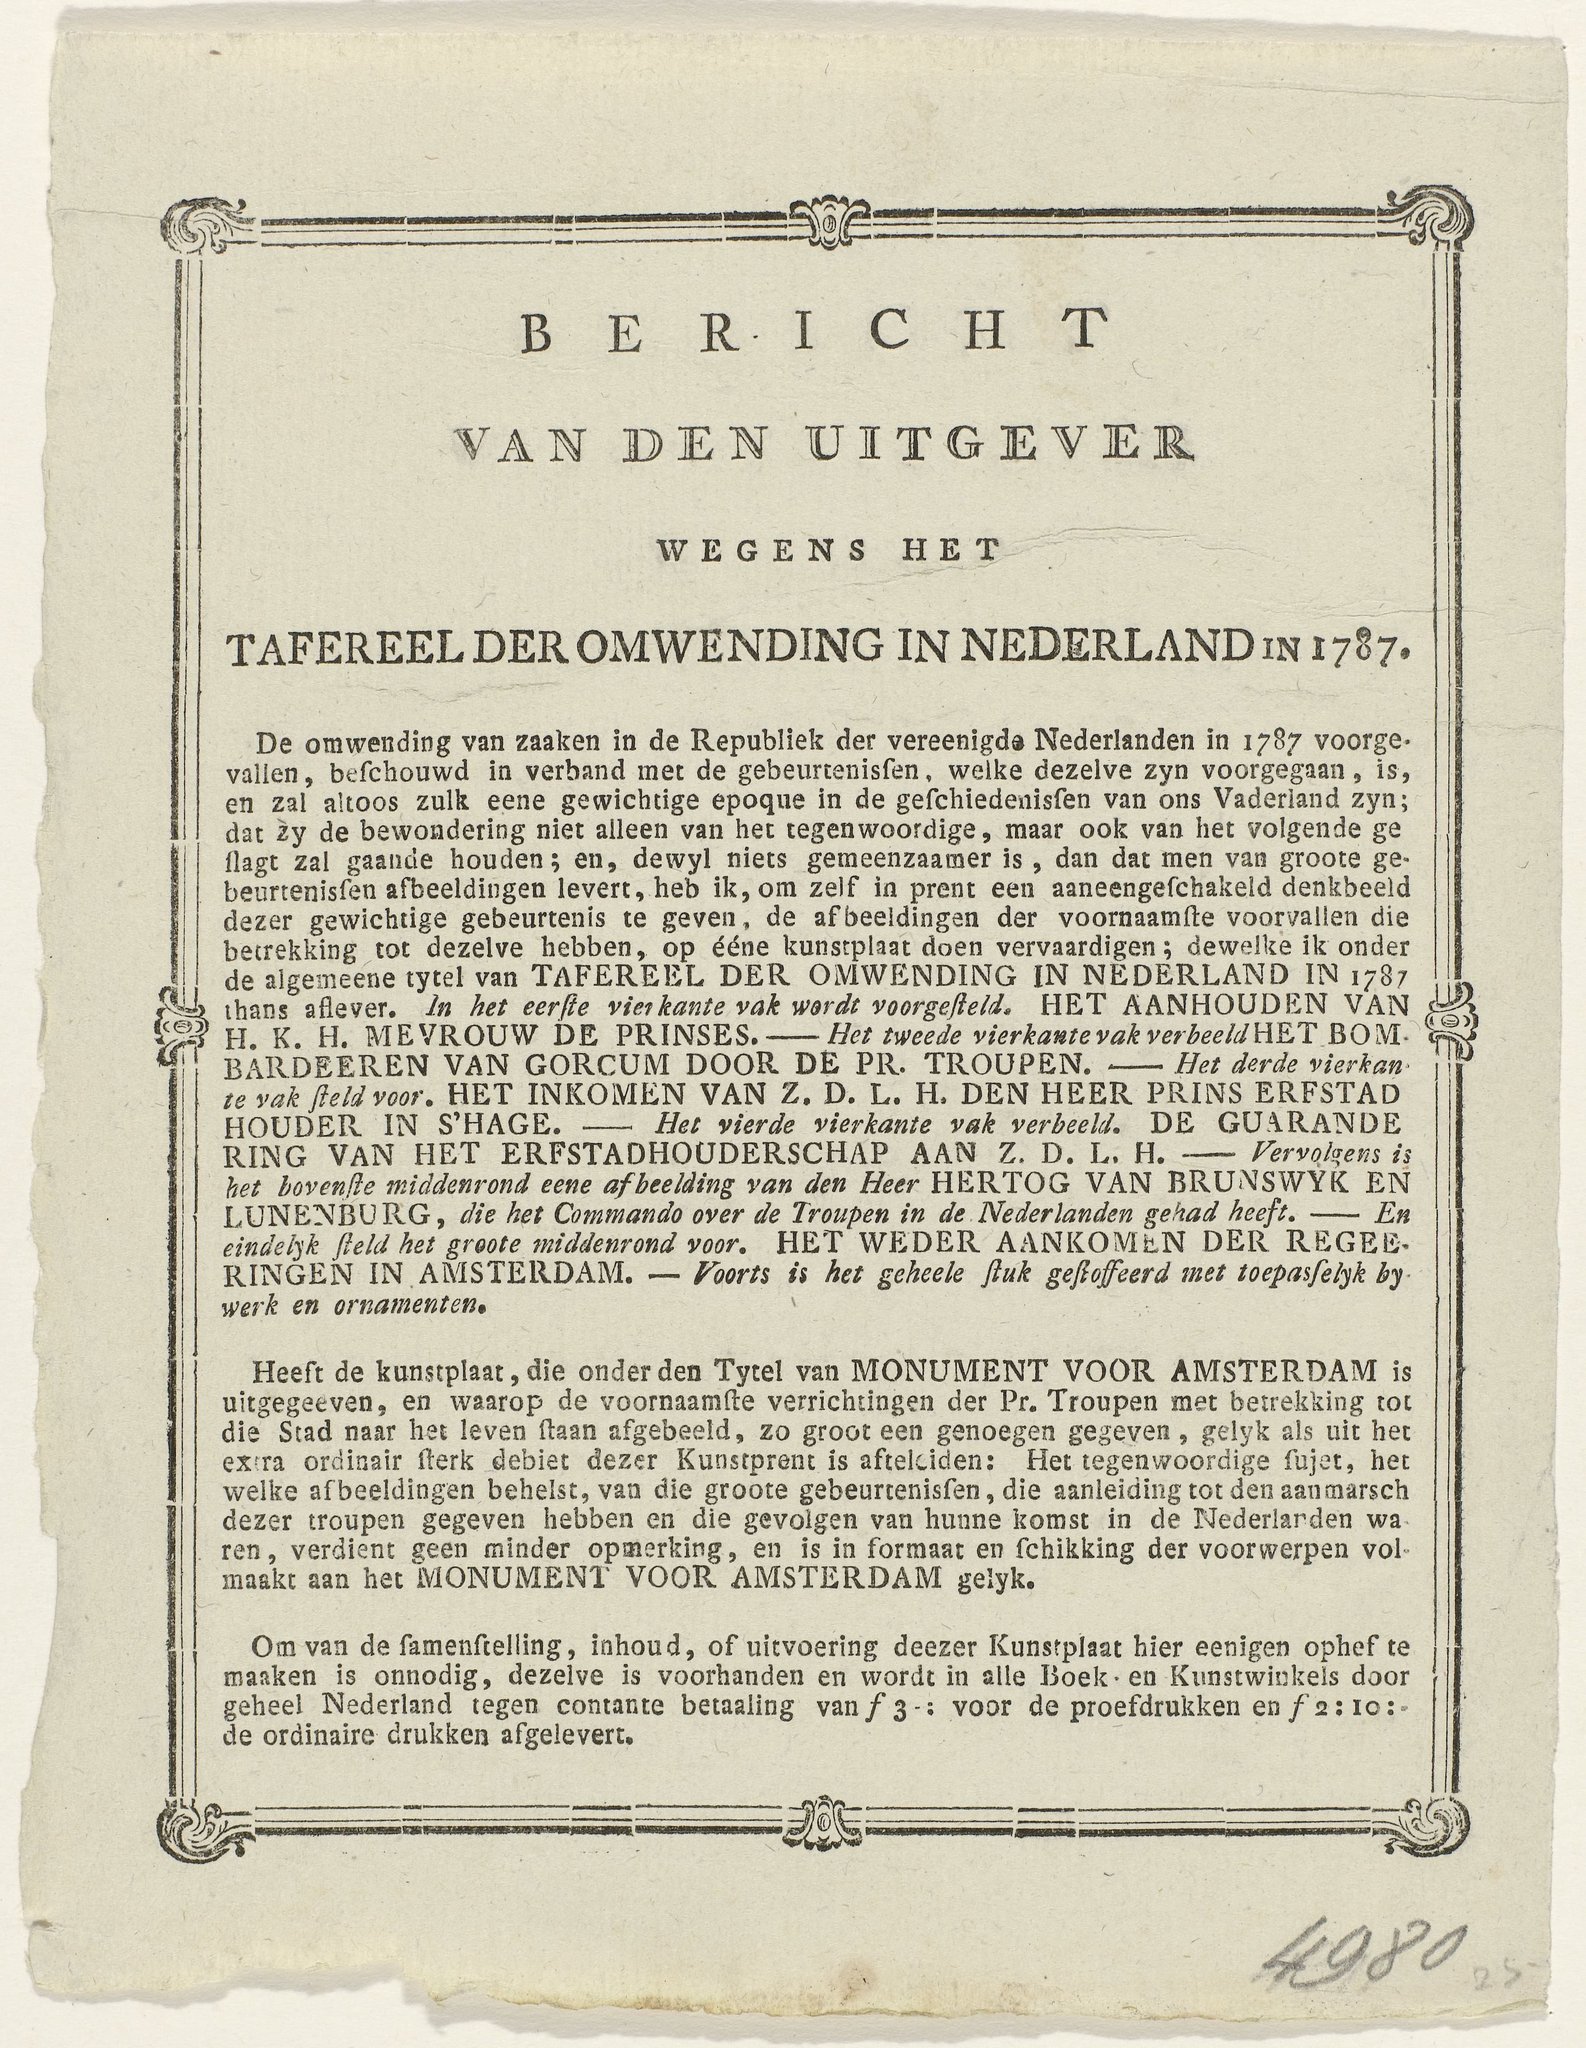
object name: text sheet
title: Bericht van de uitgever over de prent Omwentelingen in 1787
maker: Anonymous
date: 1789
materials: paper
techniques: letterpress printing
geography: northern netherlands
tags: patriots (1780-1795)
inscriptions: collector's mark: Lugt 2228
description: Bericht van de uitgever behorend bij de prent Omwentelingen in 1787. Over het belang van de prent, uitleg van de voorstellingen en opgave van de prijzen van de uitgave.